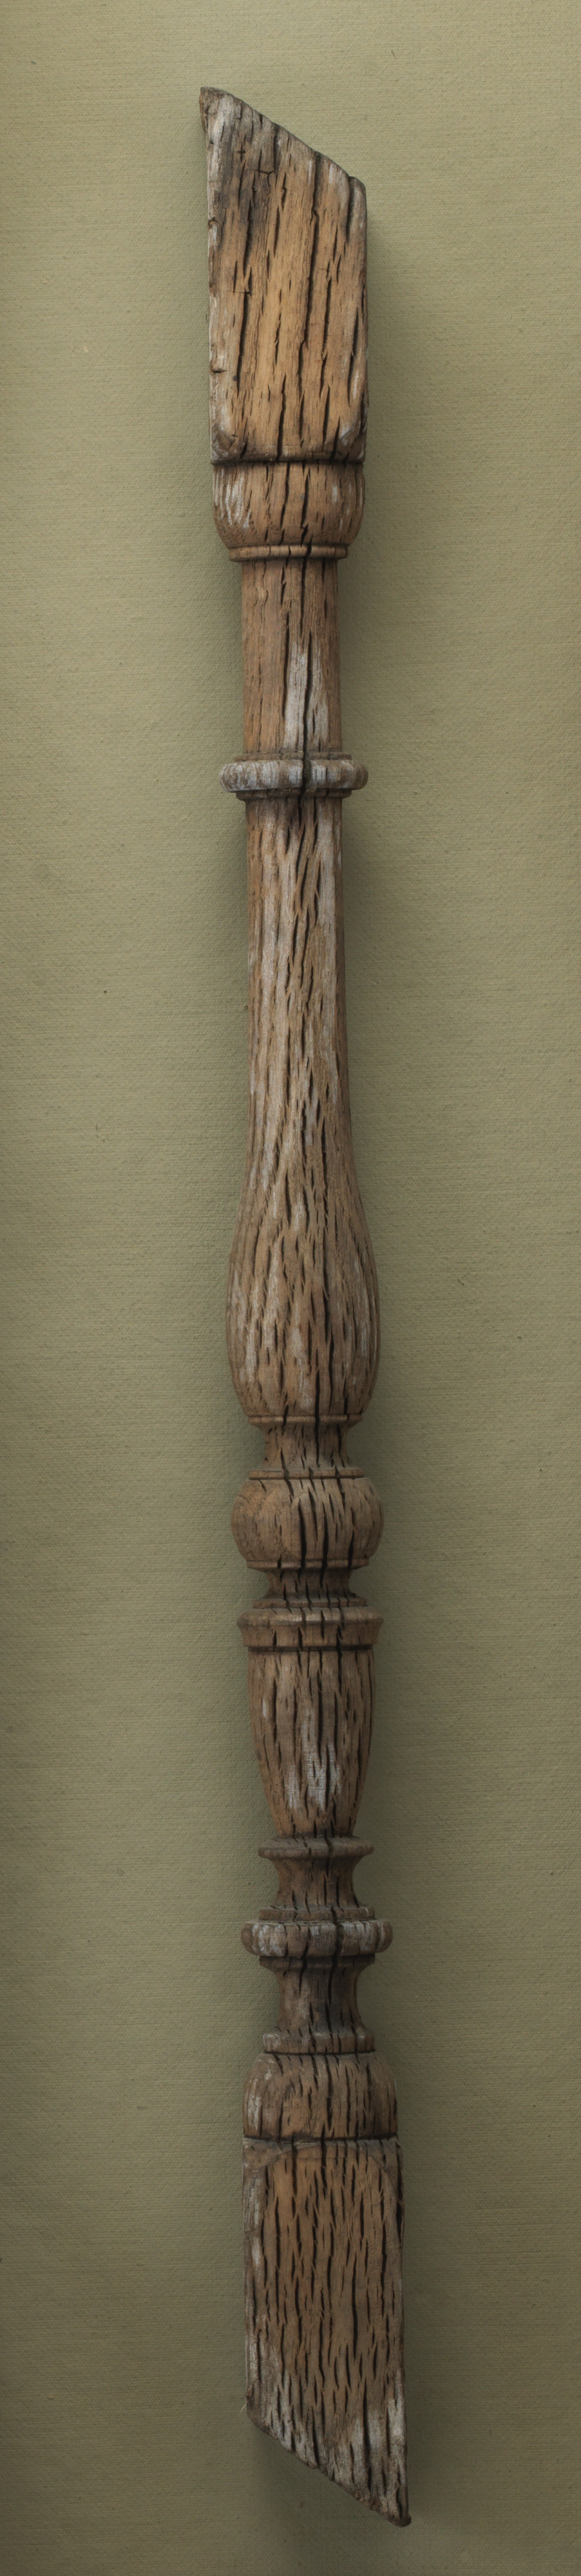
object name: baluster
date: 1701-1750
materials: wood